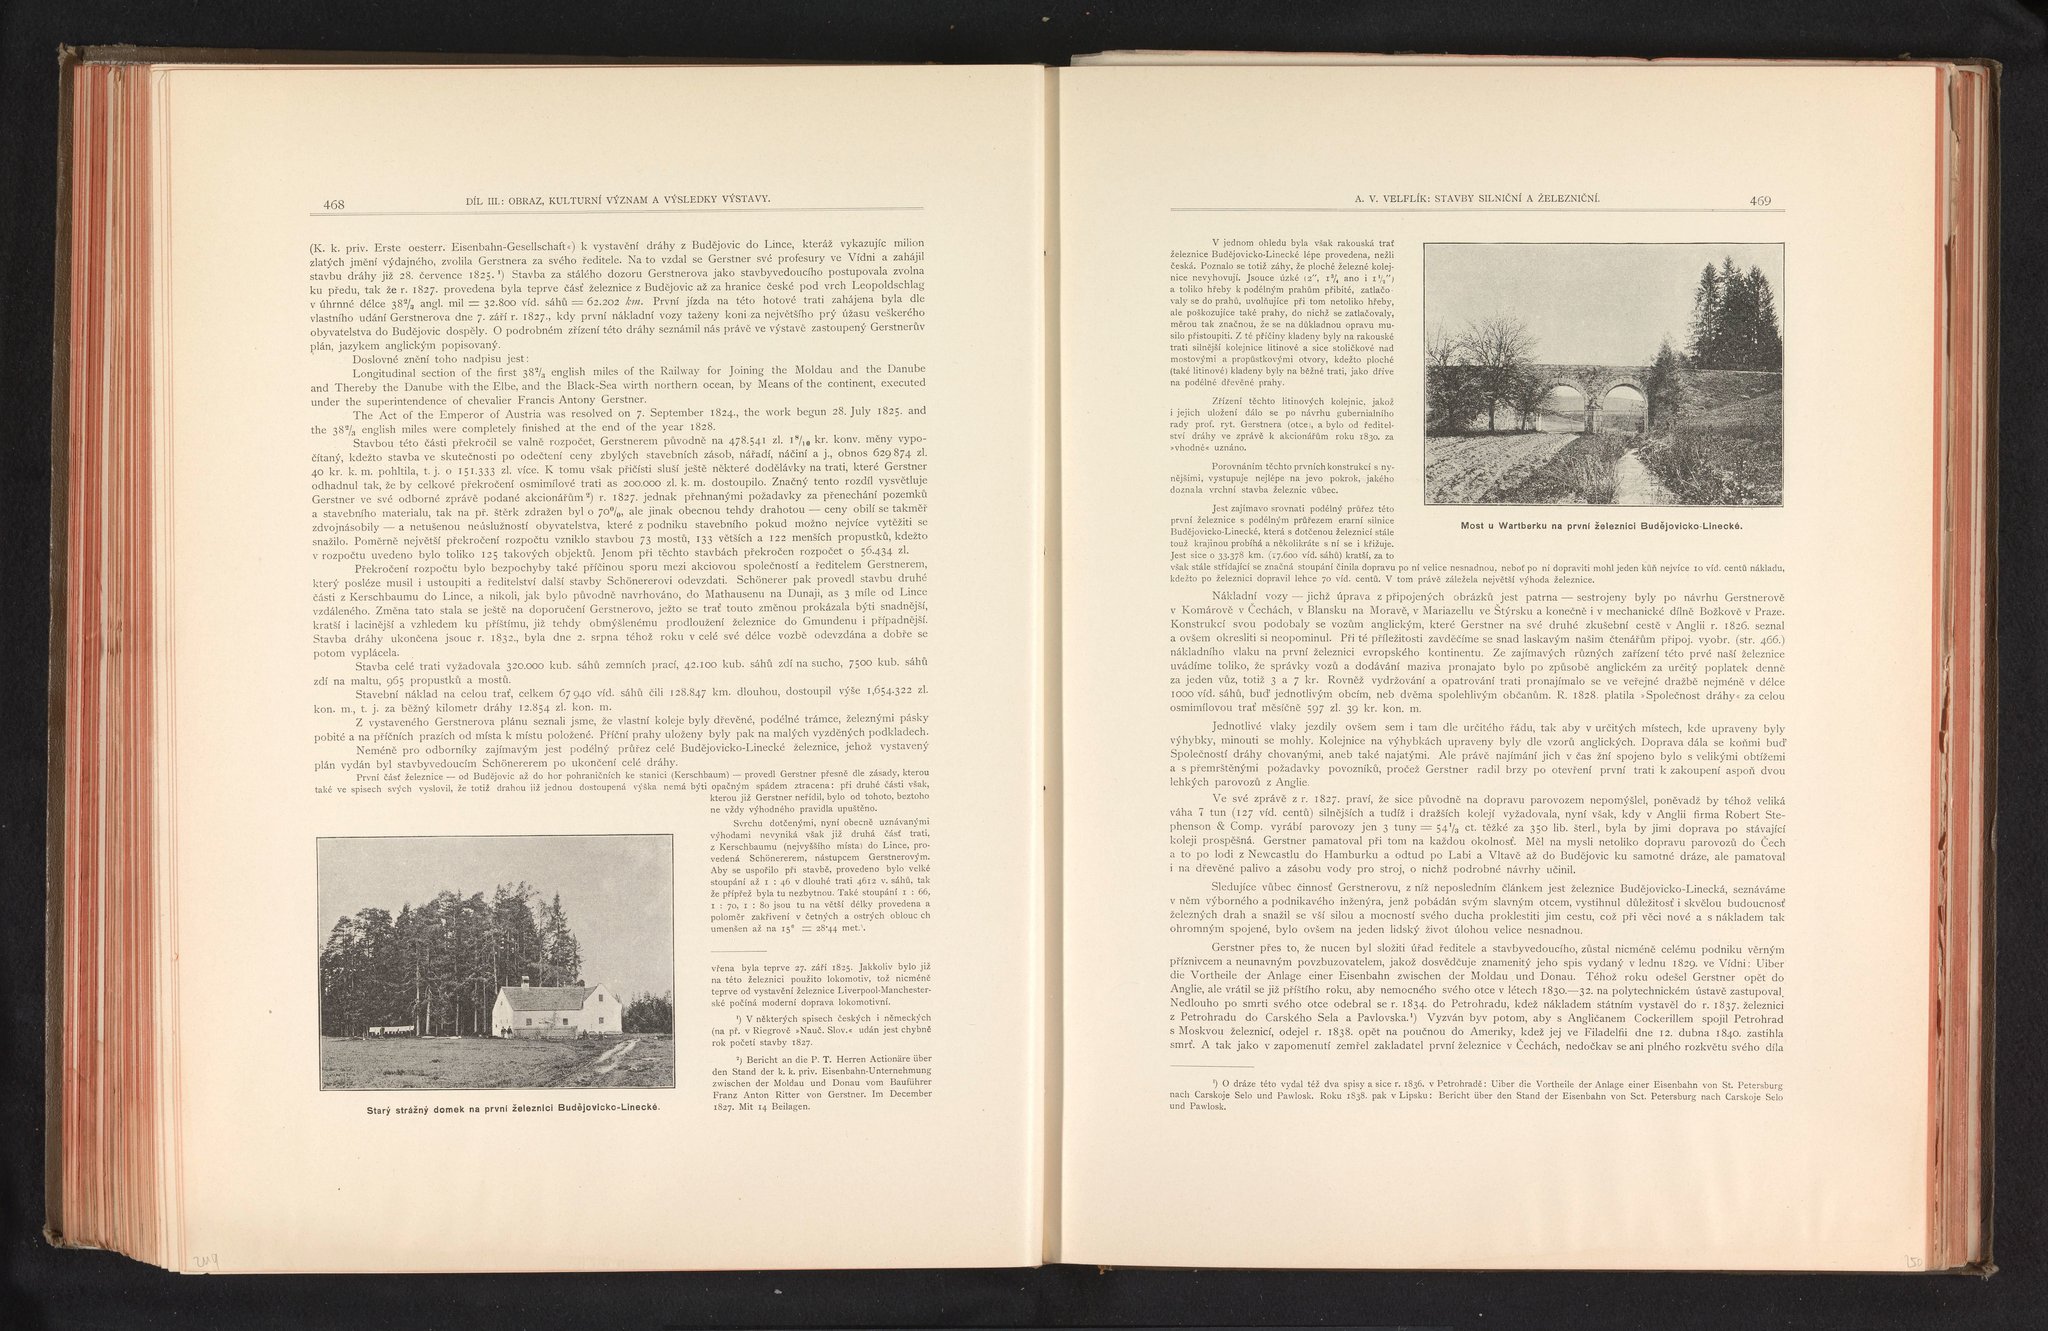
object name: page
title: Spoorbrug langs de Budejovice-Linec-spoorlijn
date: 1891-1895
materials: paper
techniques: autotype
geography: czech republic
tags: landscape with bridge, viaduct or aqueduct, railway, tramway; rack railway